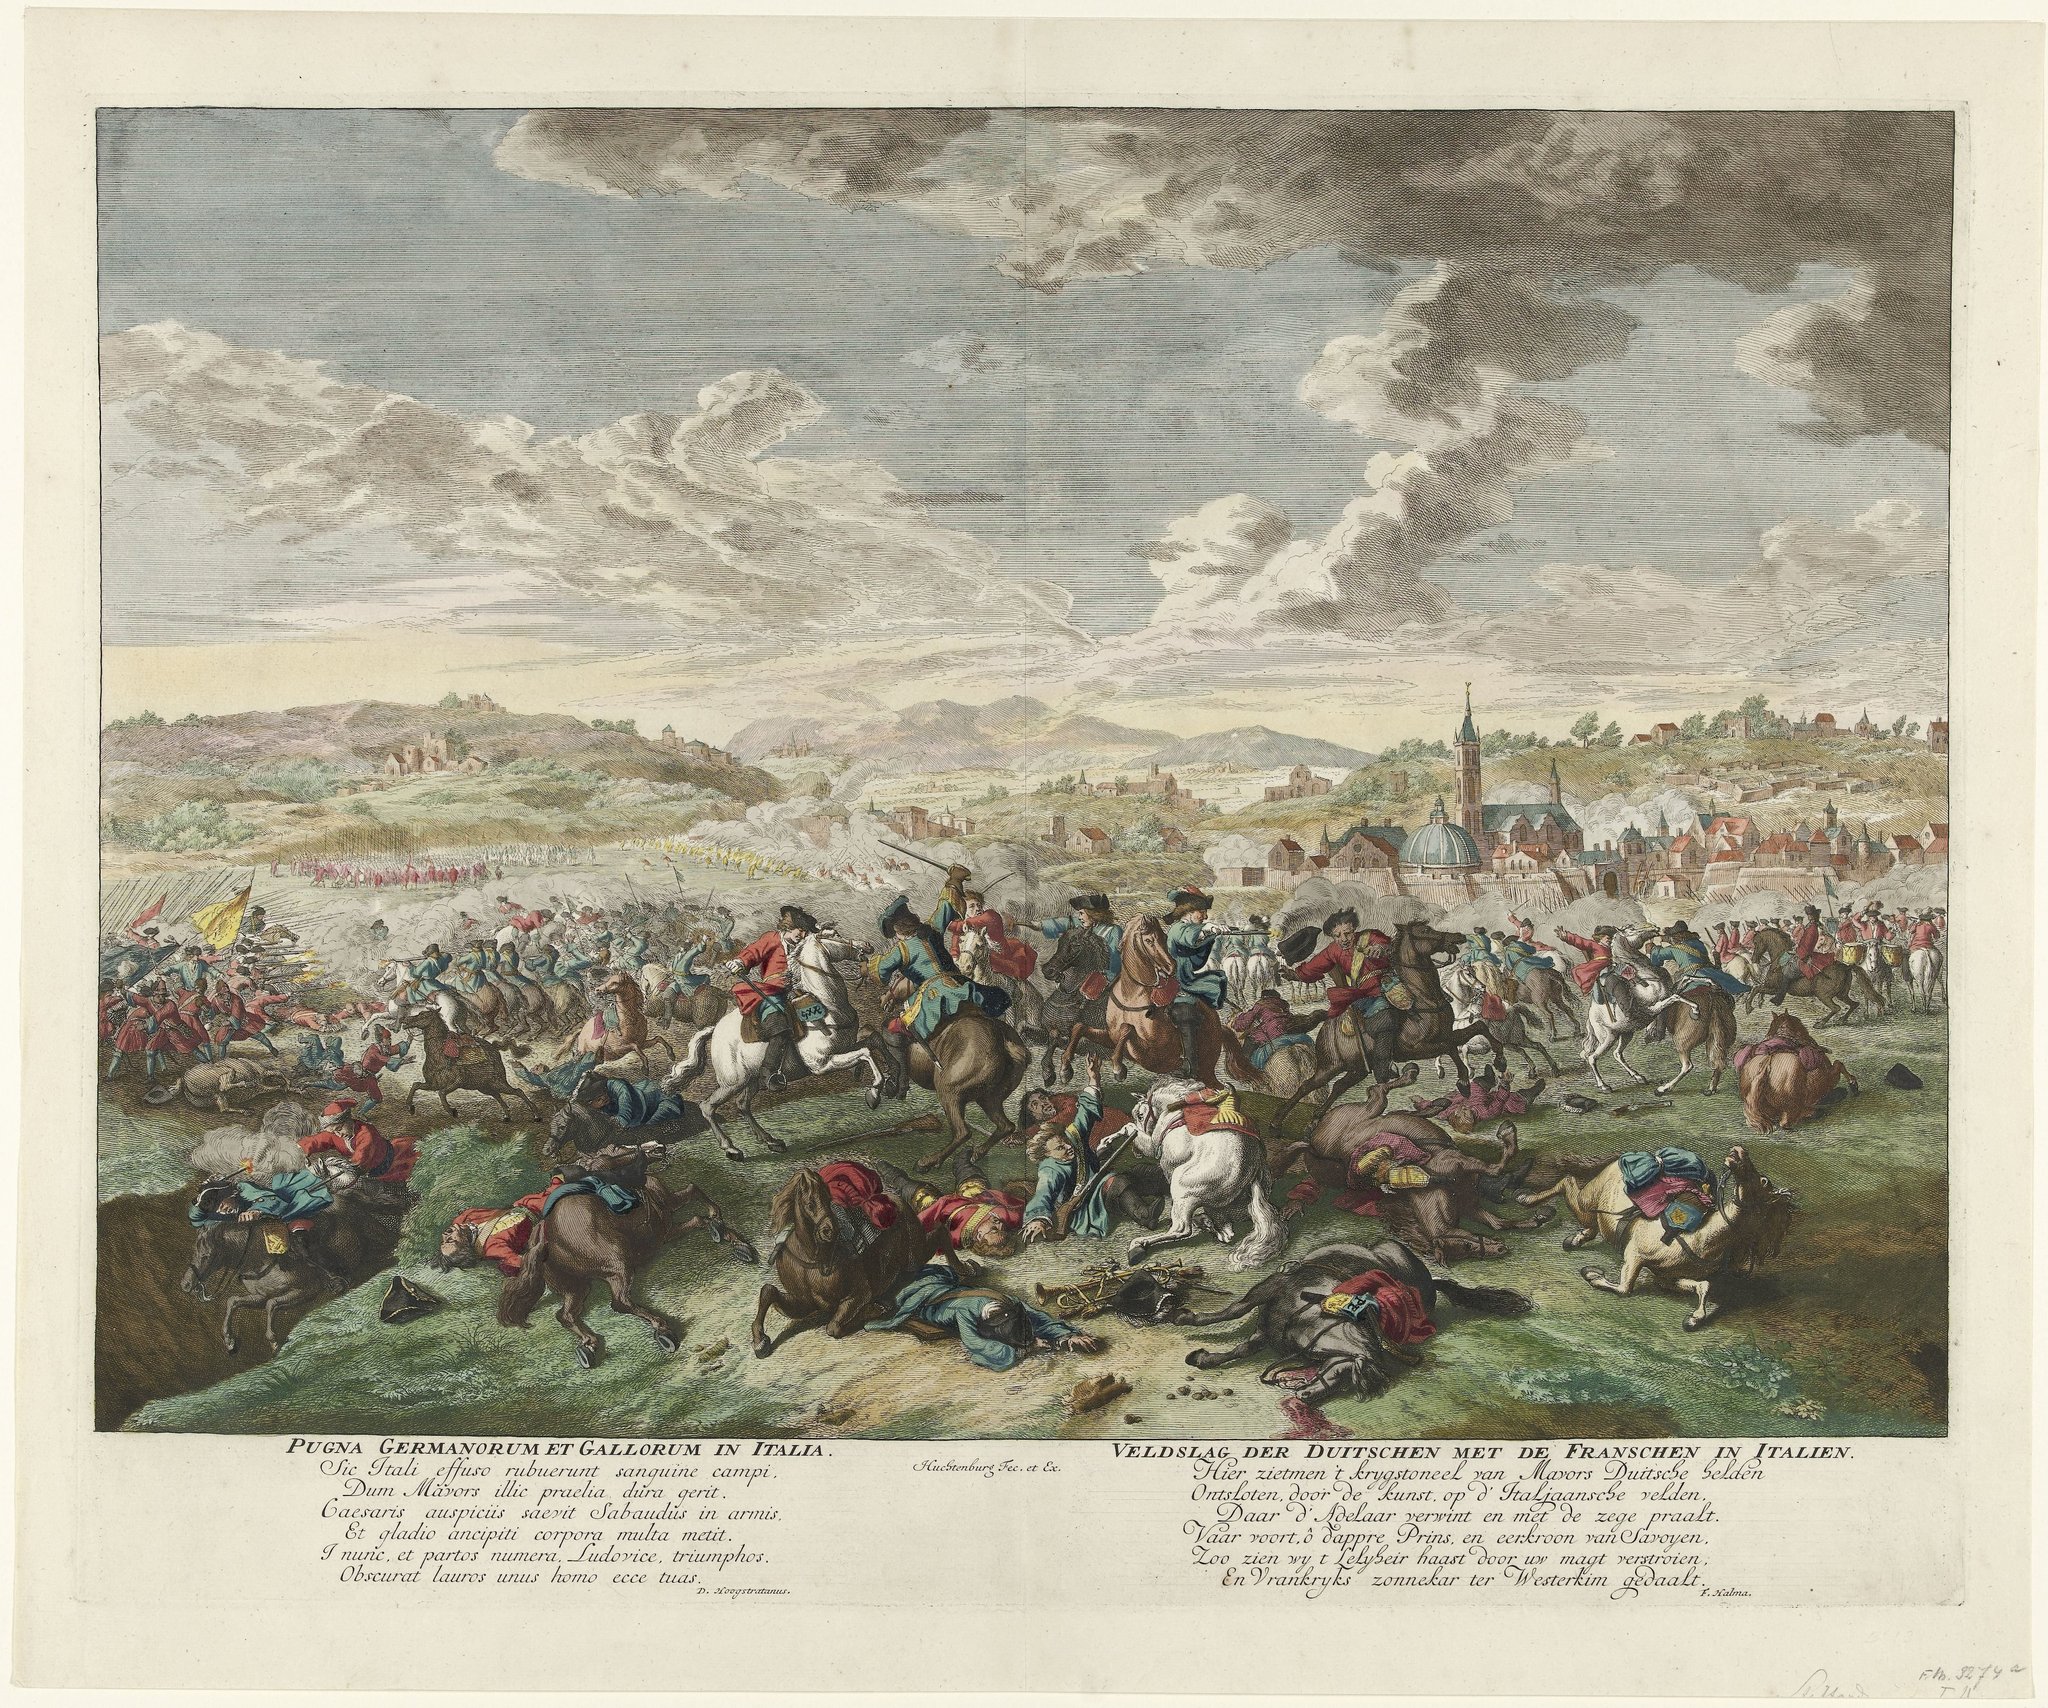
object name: print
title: Pugna Germanorum et Gallorum in Italia / Veldslag der Duitschen met de Franschen in Italien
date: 1702-1703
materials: paper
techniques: etching, hand coloring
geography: northern netherlands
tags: battle (+ land forces)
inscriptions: collector's mark: Lugt 2228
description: Gezicht op een woest ruitergevecht tussen Keizerlijke en Franse troepen in Noord-Italië, ten tijde van de Spaanse Successieoorlog, ca. 1702-1703. In het onderschrift verzen in het Latijn en Nederlands.